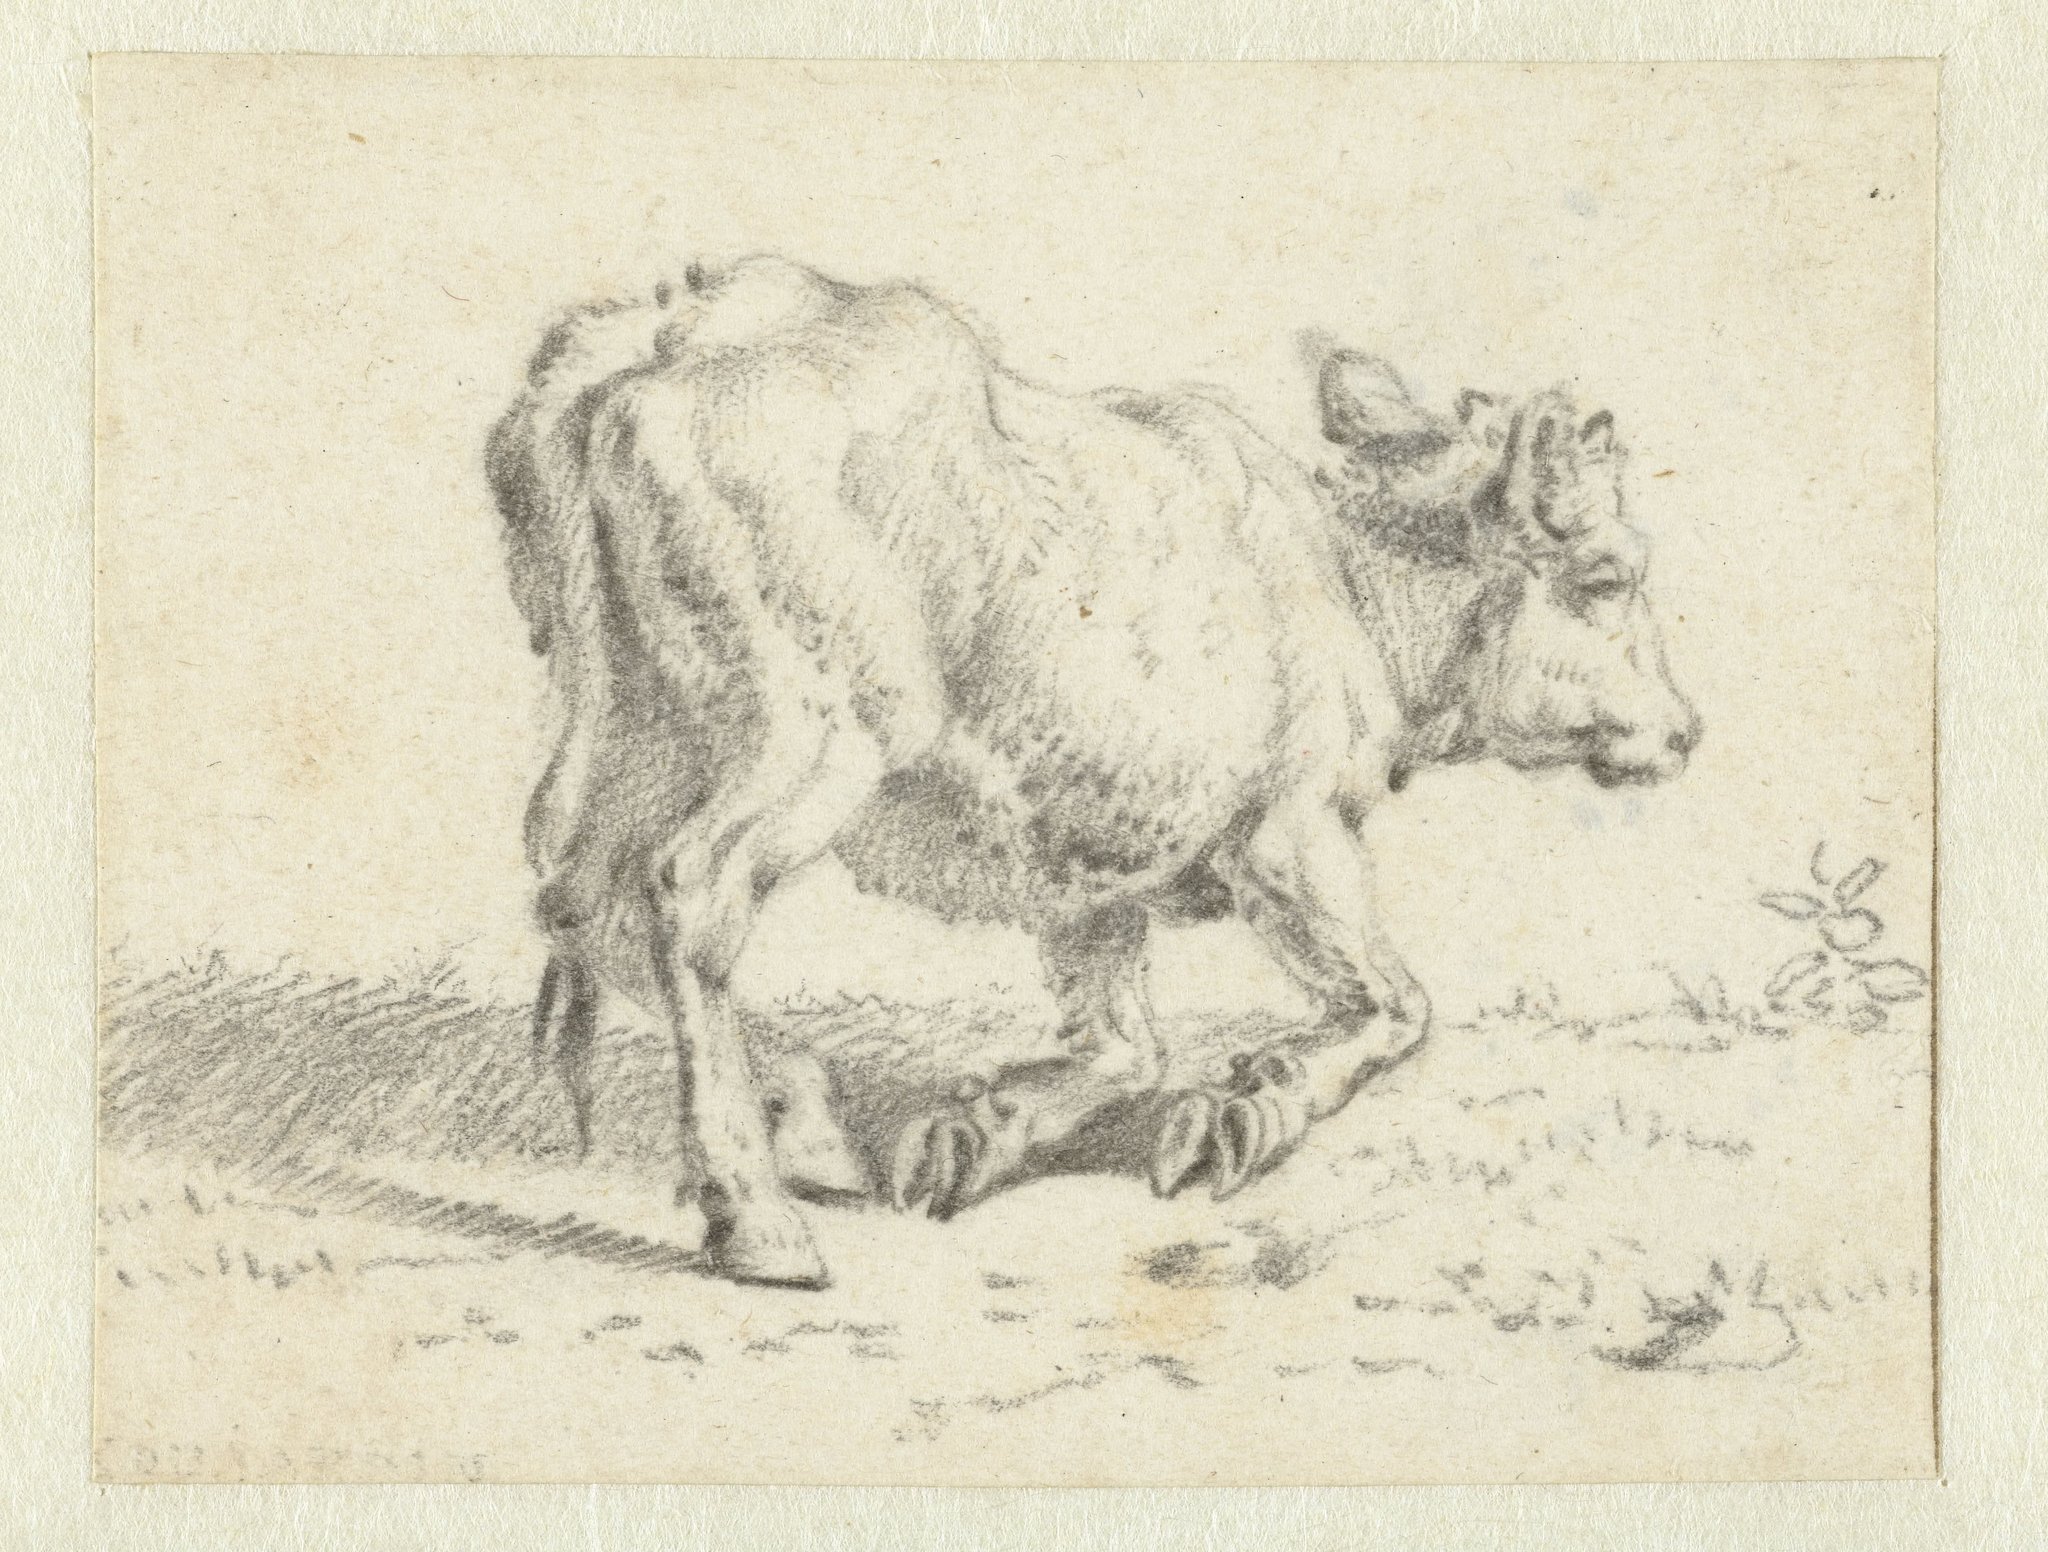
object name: drawing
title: Knielend kalf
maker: karel du jardin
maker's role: draughtsman, painter, print maker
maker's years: 1626-1678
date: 1632-1678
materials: chalk, paper